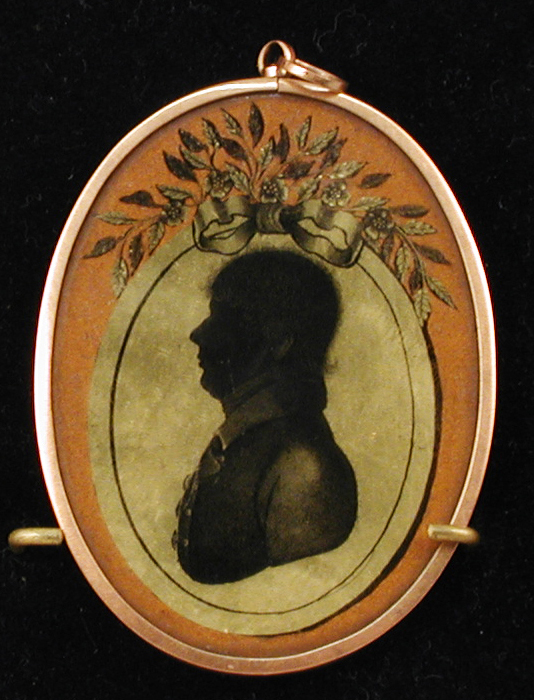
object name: pendant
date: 1801-1833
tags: men,profiles